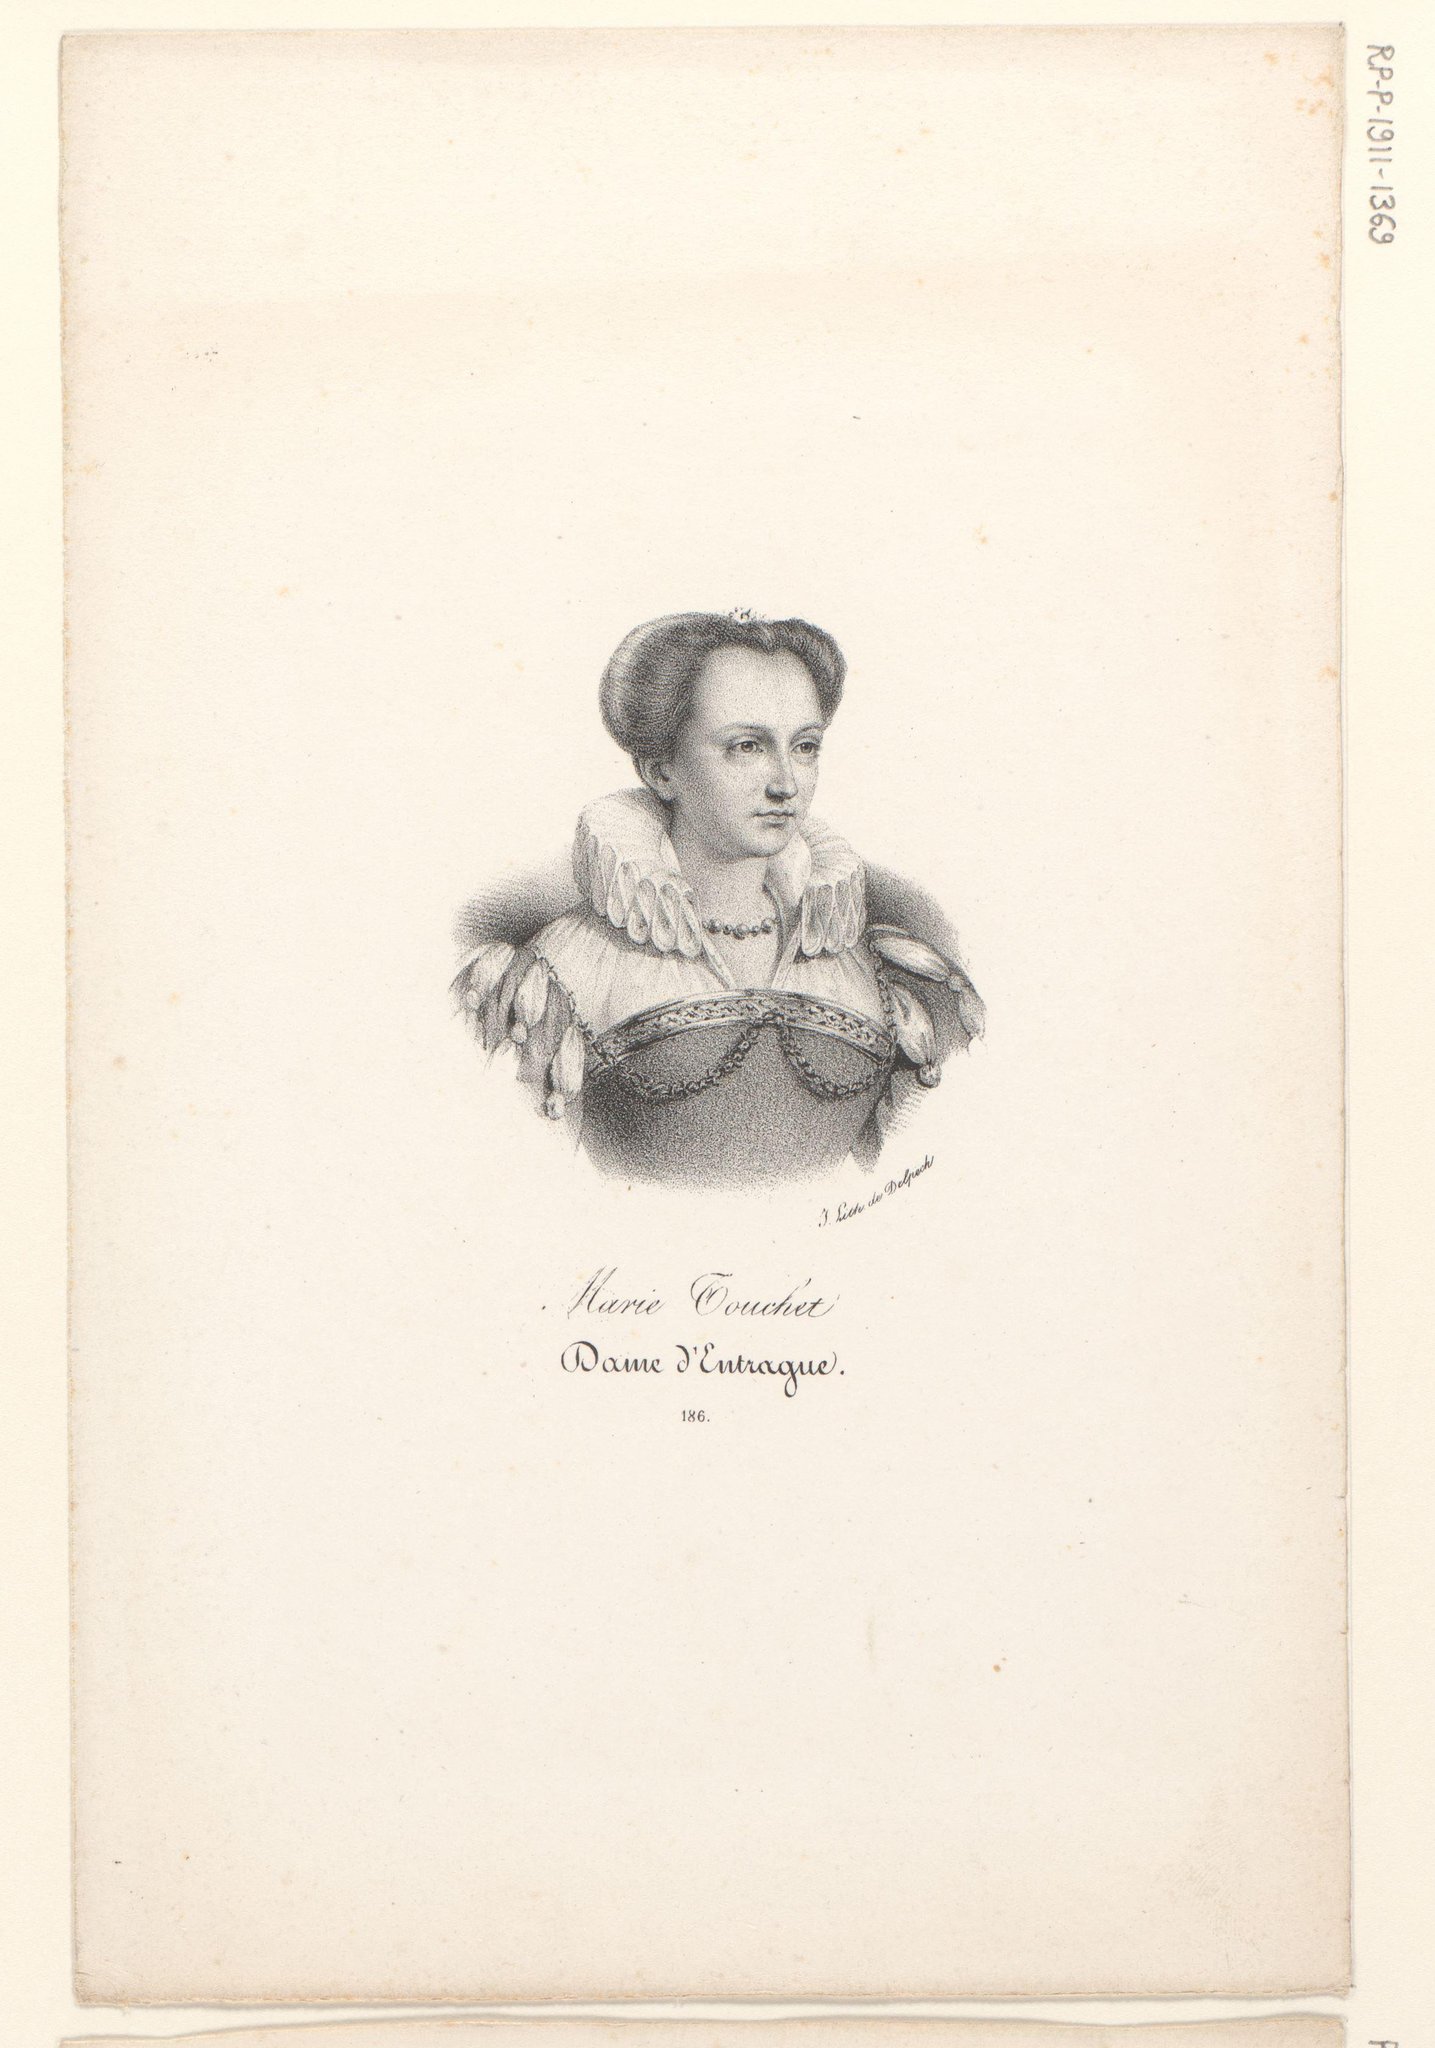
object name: print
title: Marie Touchet, dame d'Entrague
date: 1818-1842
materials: paper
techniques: lithograph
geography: paris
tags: paris, historical persons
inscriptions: collector's mark: Lugt 2228a